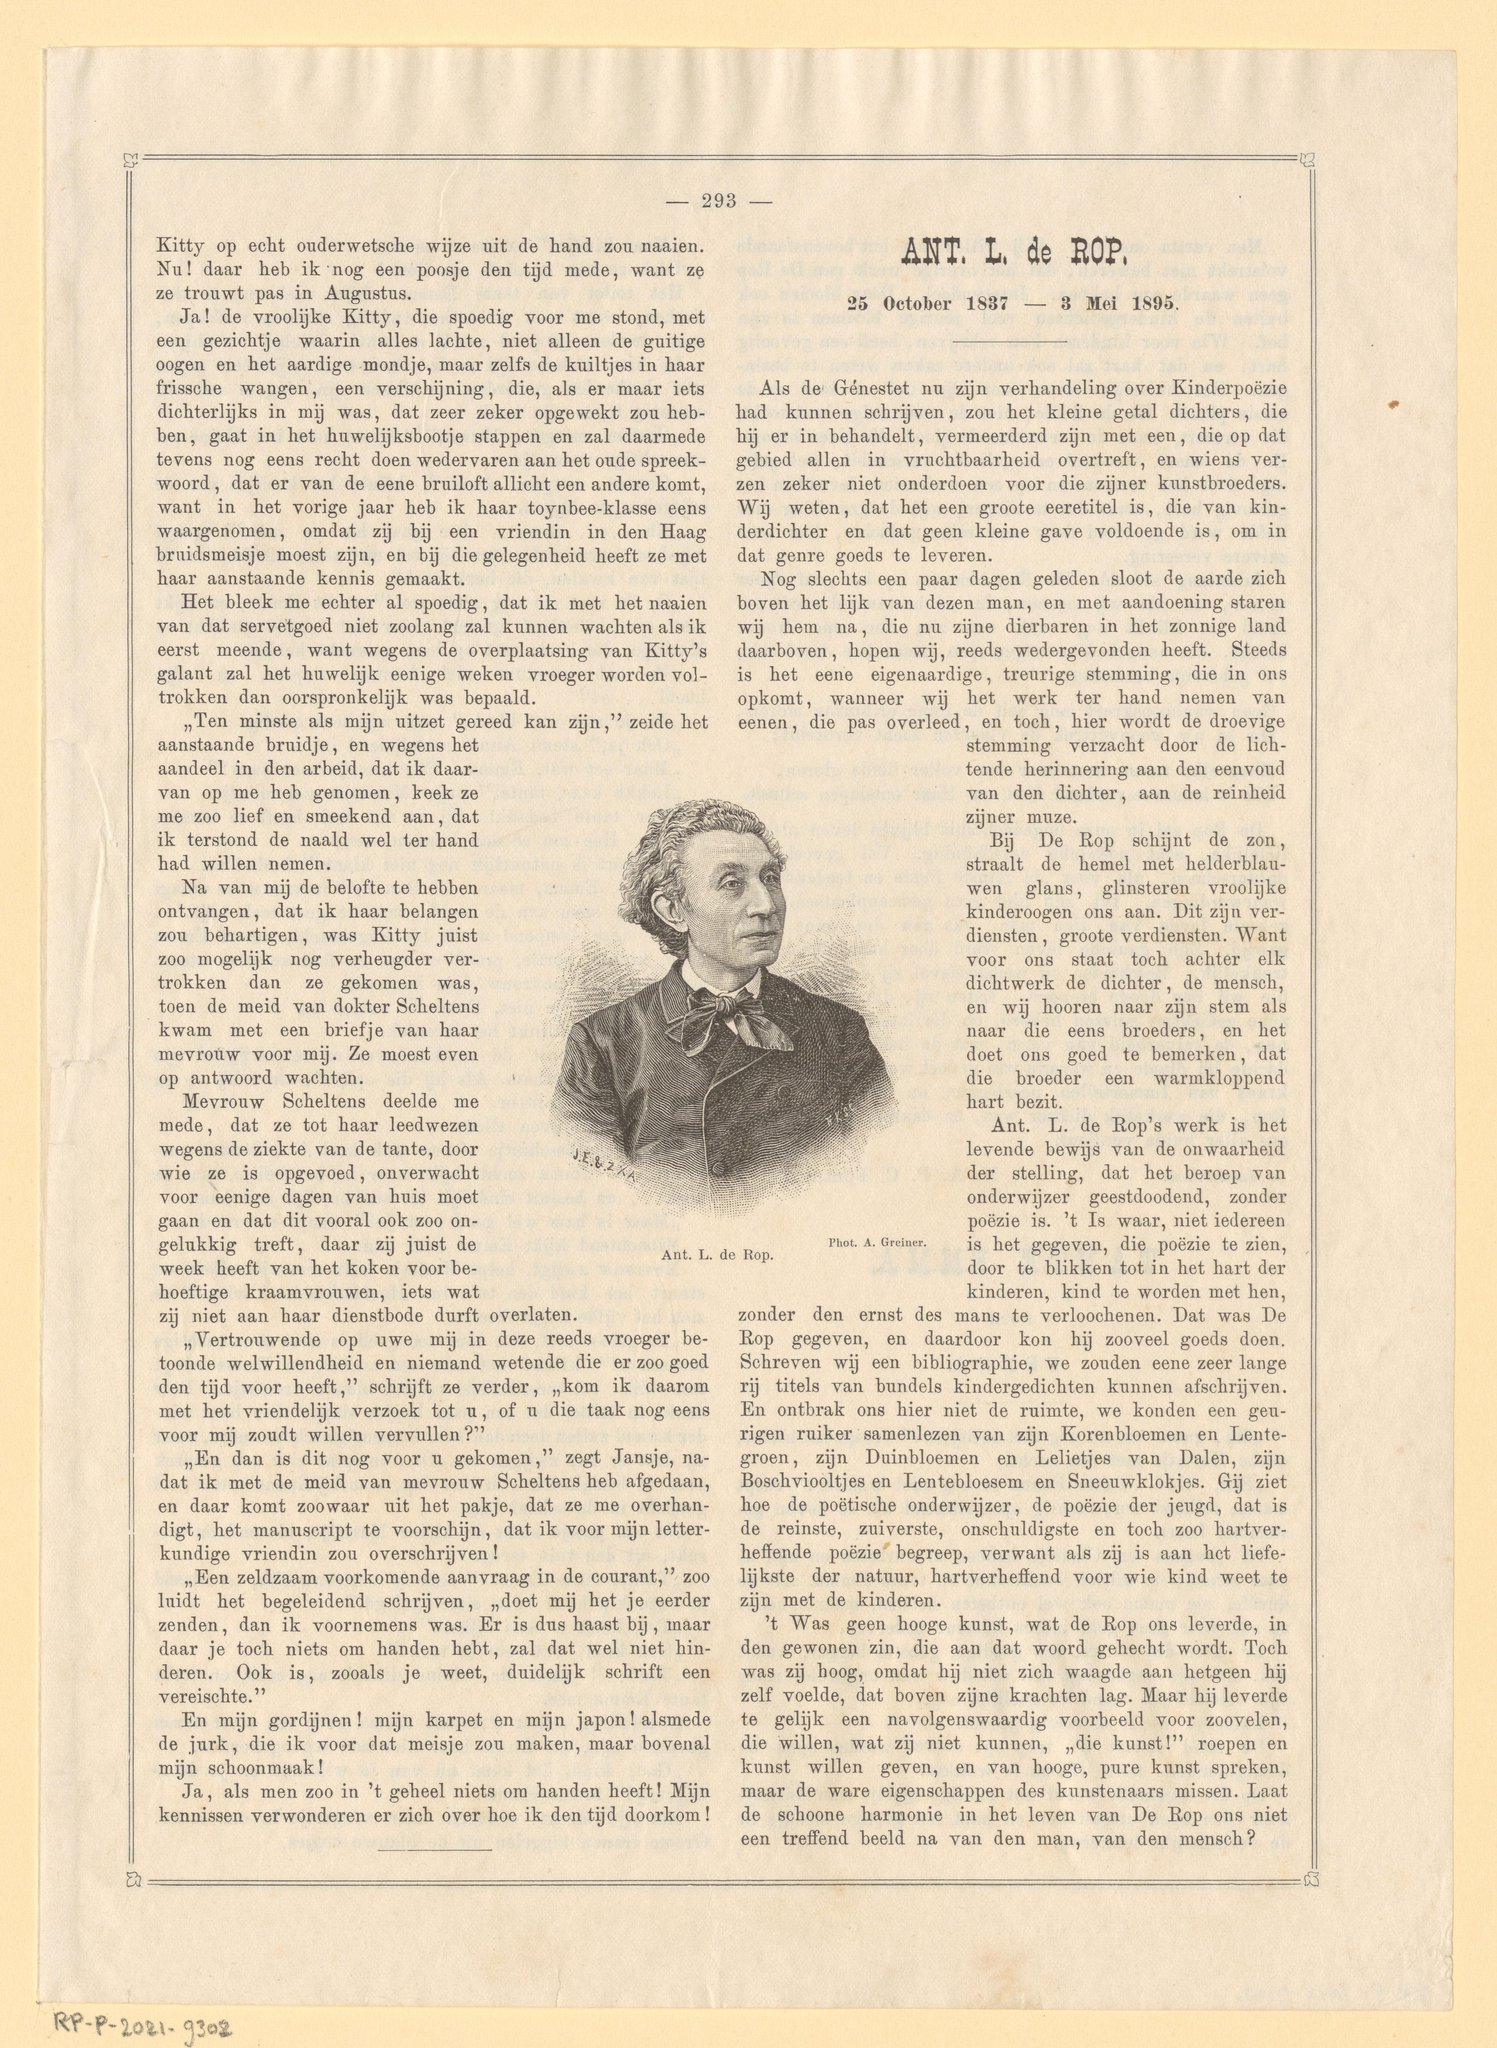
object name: print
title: Portret van Antoon Leonard de Rop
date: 1895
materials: paper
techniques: letterpress printing, engraving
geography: haarlem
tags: antoon leonard de rop, historical persons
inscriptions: signature: ‘FKSC’, signature: ‘J.E. &. Z XA’